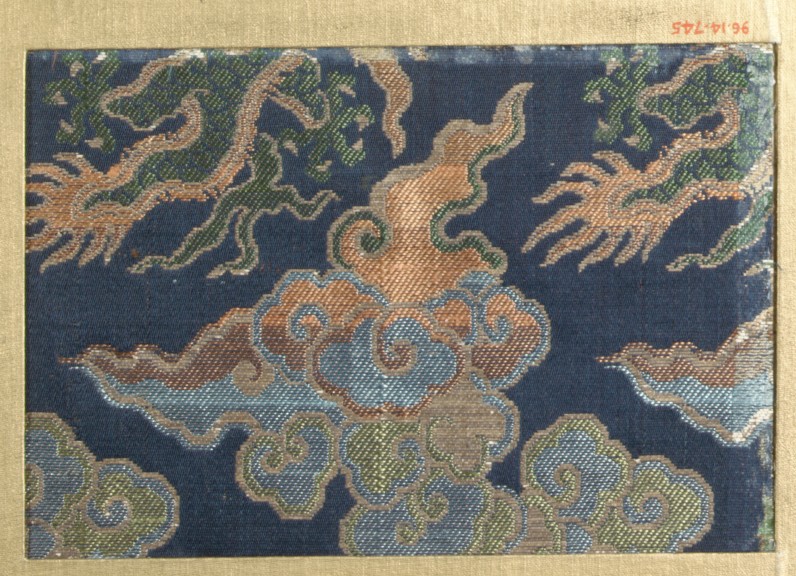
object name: piece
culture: chinese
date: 1701-1900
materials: silk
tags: dragons,clouds